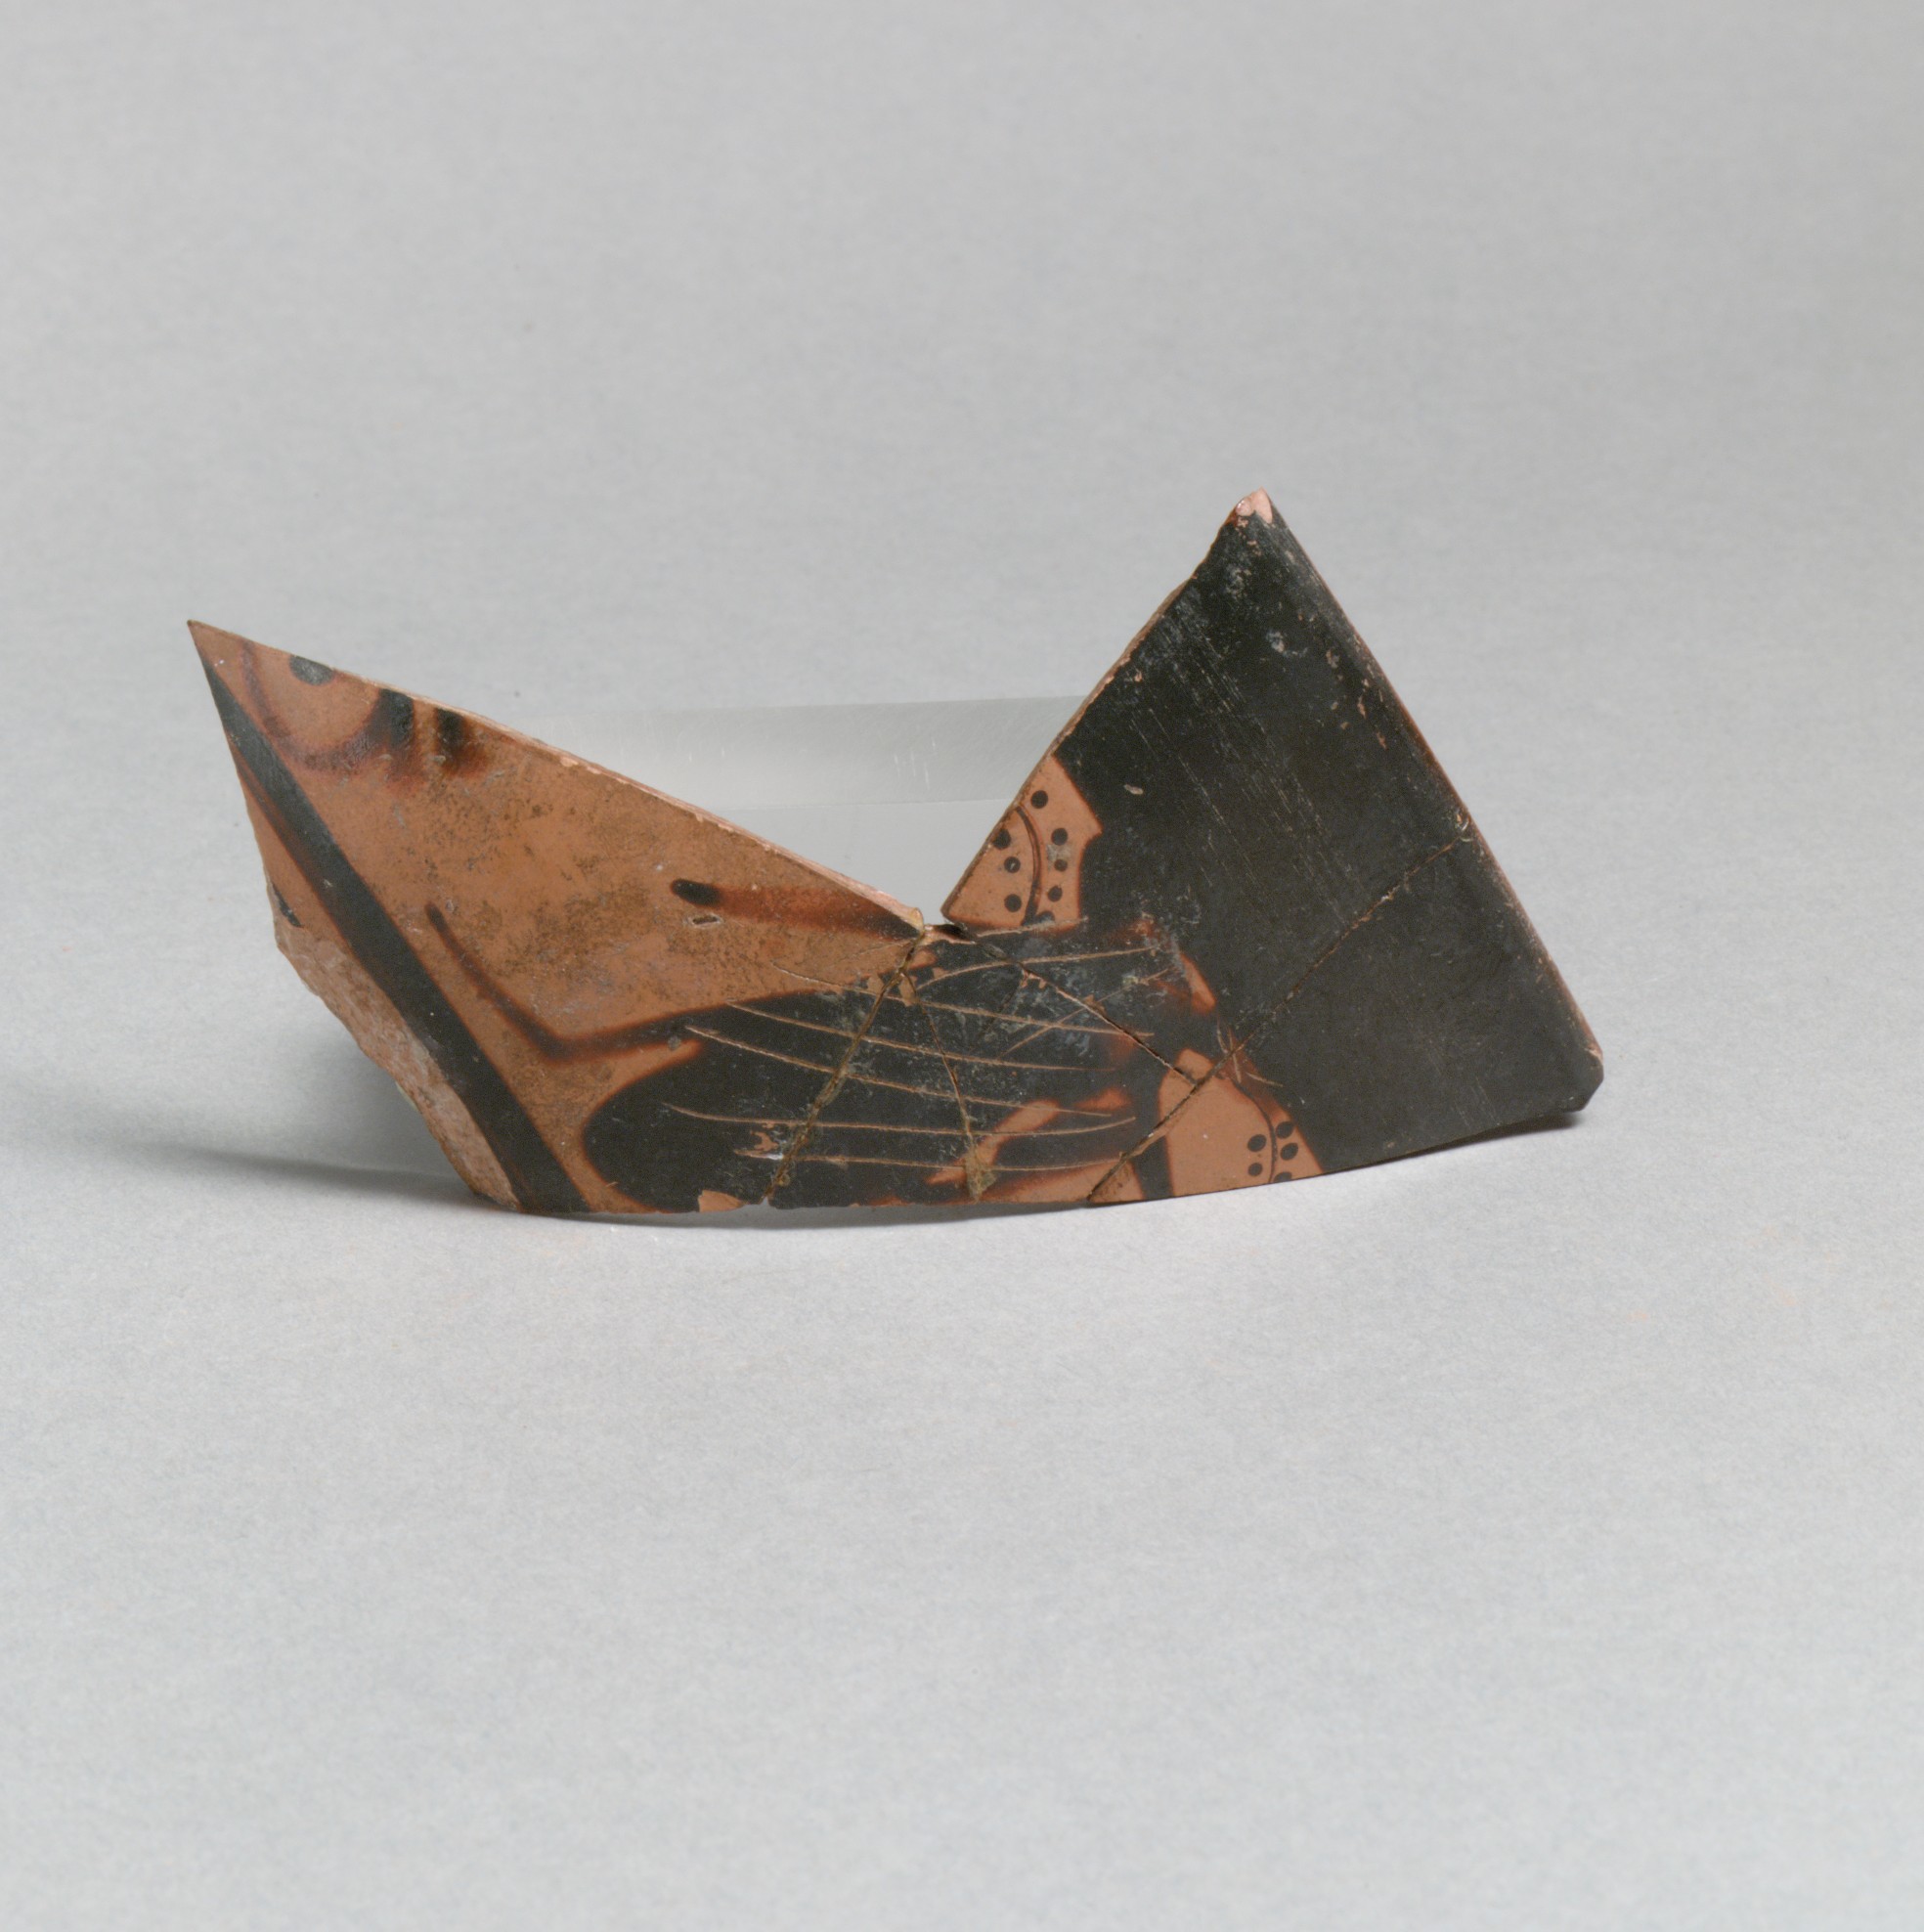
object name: skyphos fragment, 4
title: Skyphos fragments, 4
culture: greek, attic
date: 500-475 BCE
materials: terracotta